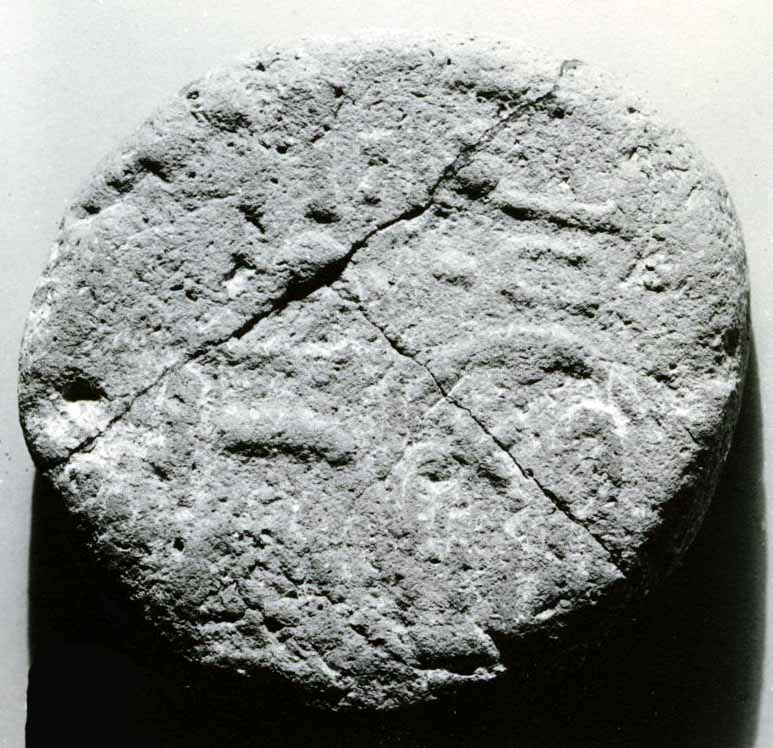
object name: cone, ahmose, tt 121, circular impression, prophet, amun, thutmose iii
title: Funerary Cone of Ahmose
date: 1479-1425 BCE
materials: pottery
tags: hieroglyphs